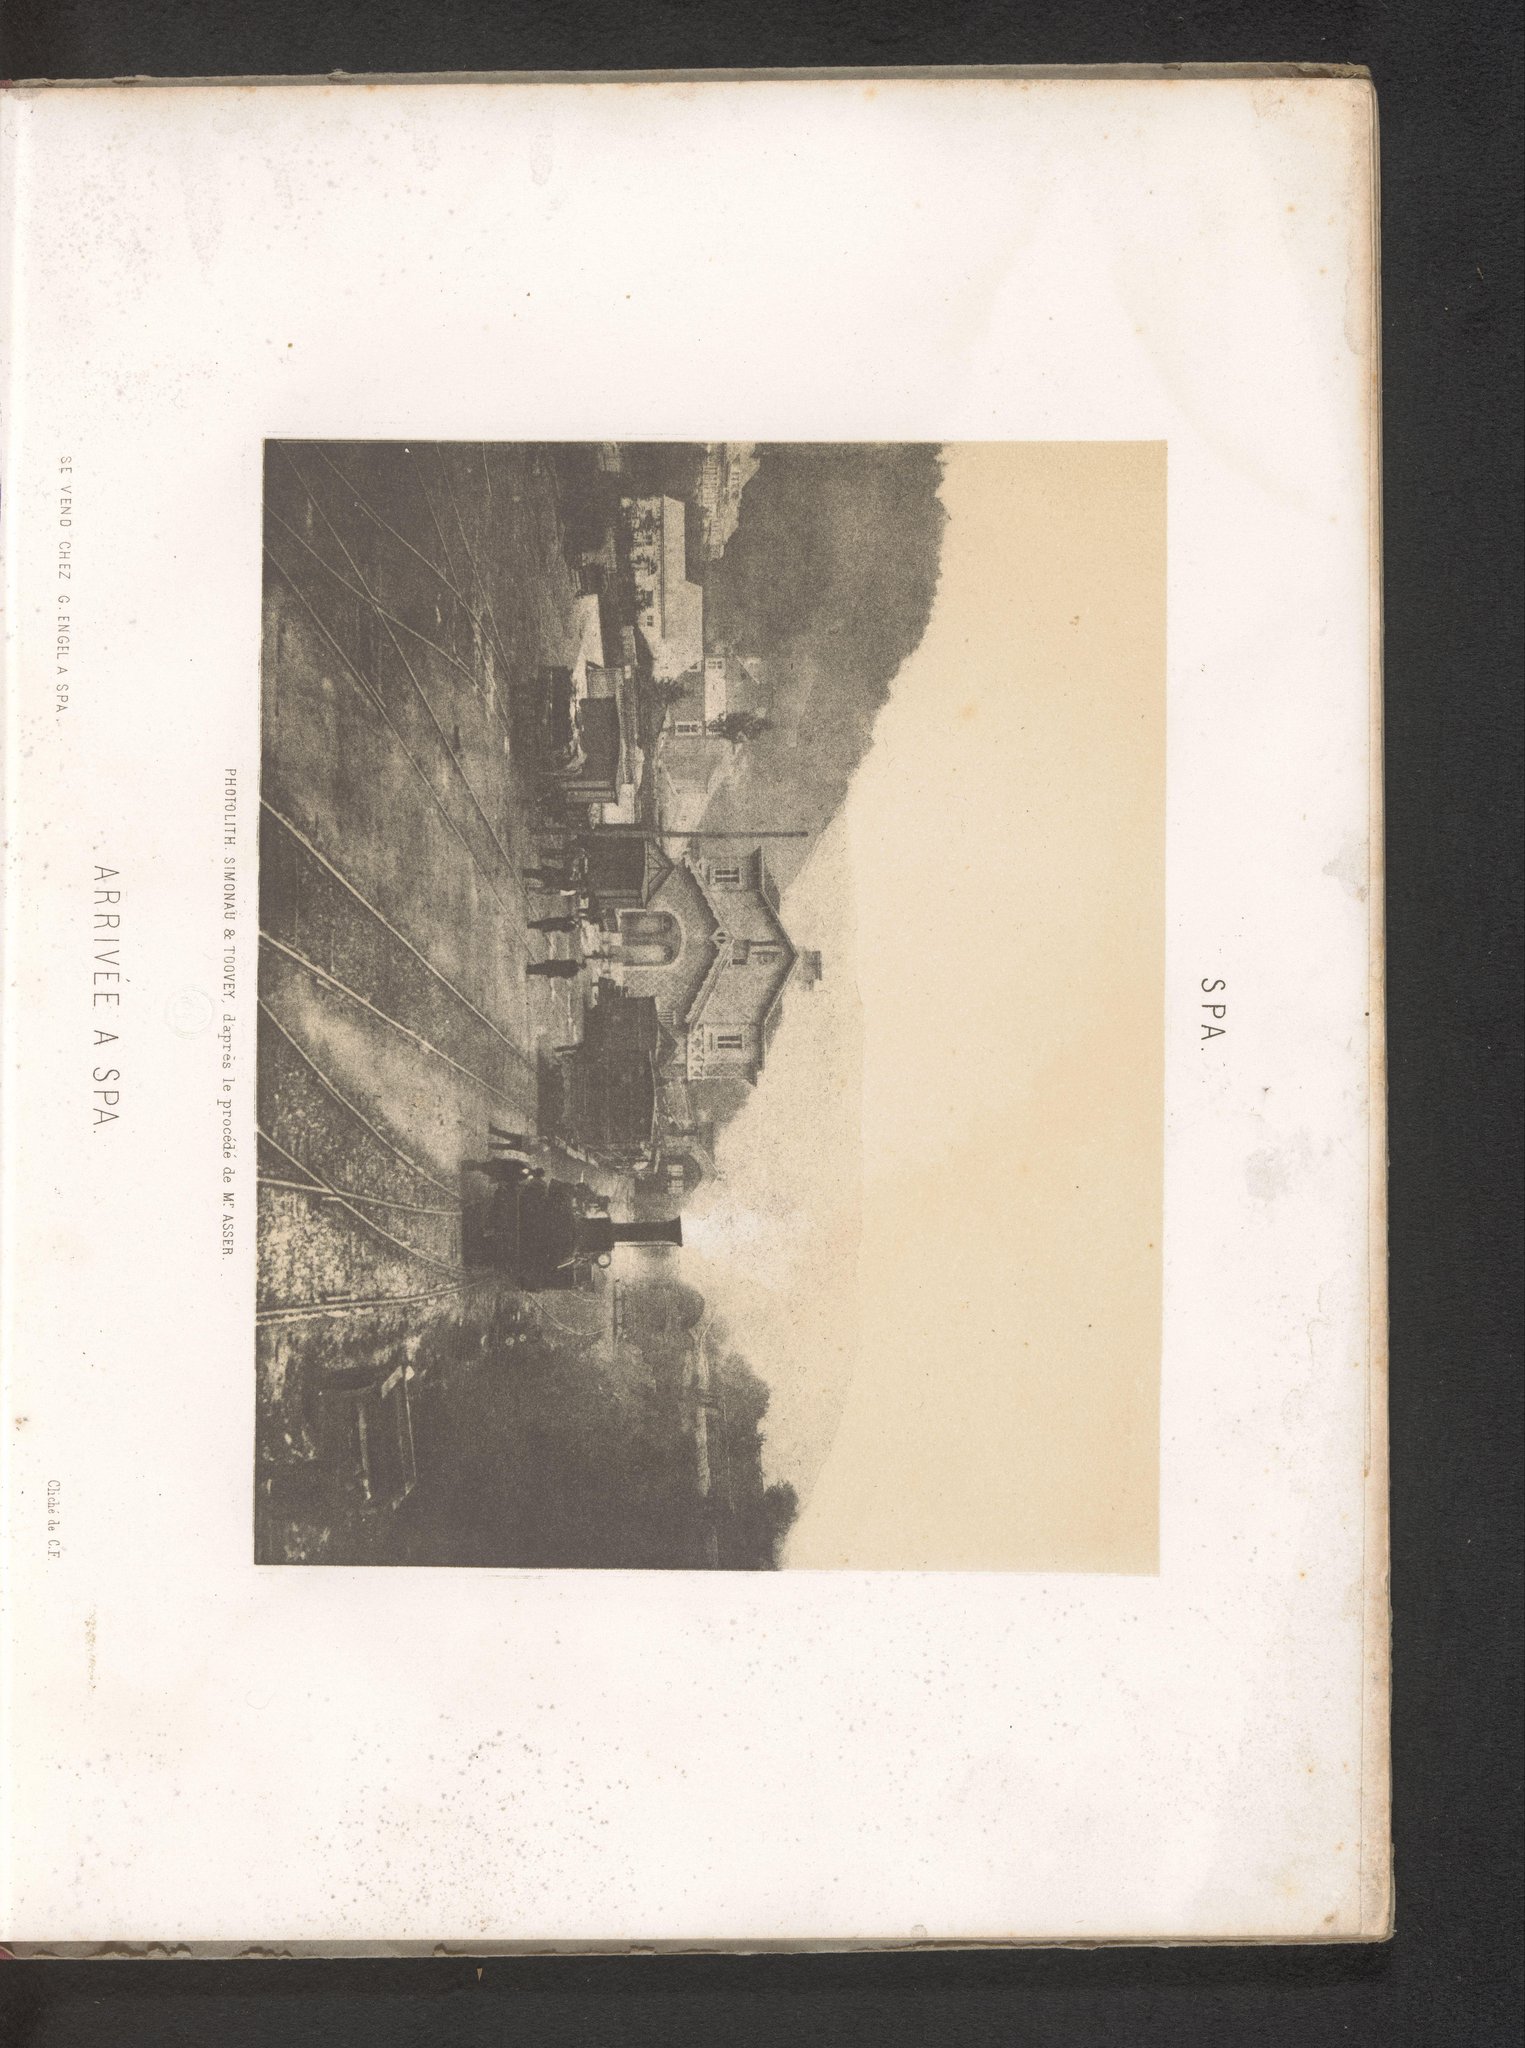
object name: photomechanical print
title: Arrivée à Spa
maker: c.f.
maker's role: fotograaf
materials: paper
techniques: photolithography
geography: brussels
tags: station; shelter (railway, tramway), prospect of city, town panorama, silhouette of city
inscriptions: inscription: ‘SE VEND CHEZ F. ENGEL A SPA.’, inscription: ‘PHOTOLITH. SIMONAU & TOOVEY, d'après le procédé de Mr. ASSER.’